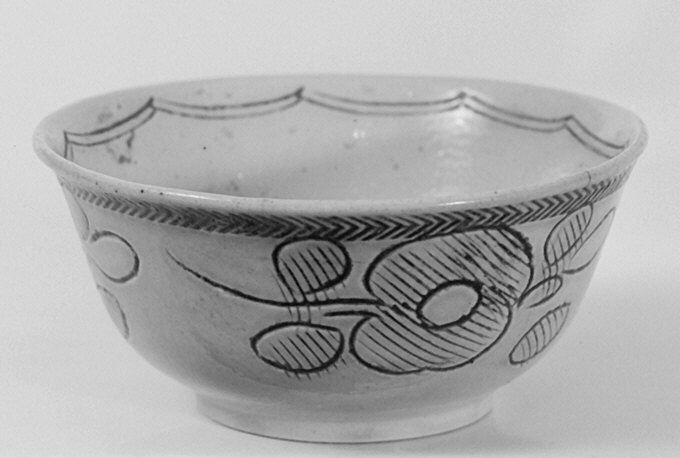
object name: cup and saucer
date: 1755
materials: stoneware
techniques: salt glaze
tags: flowers